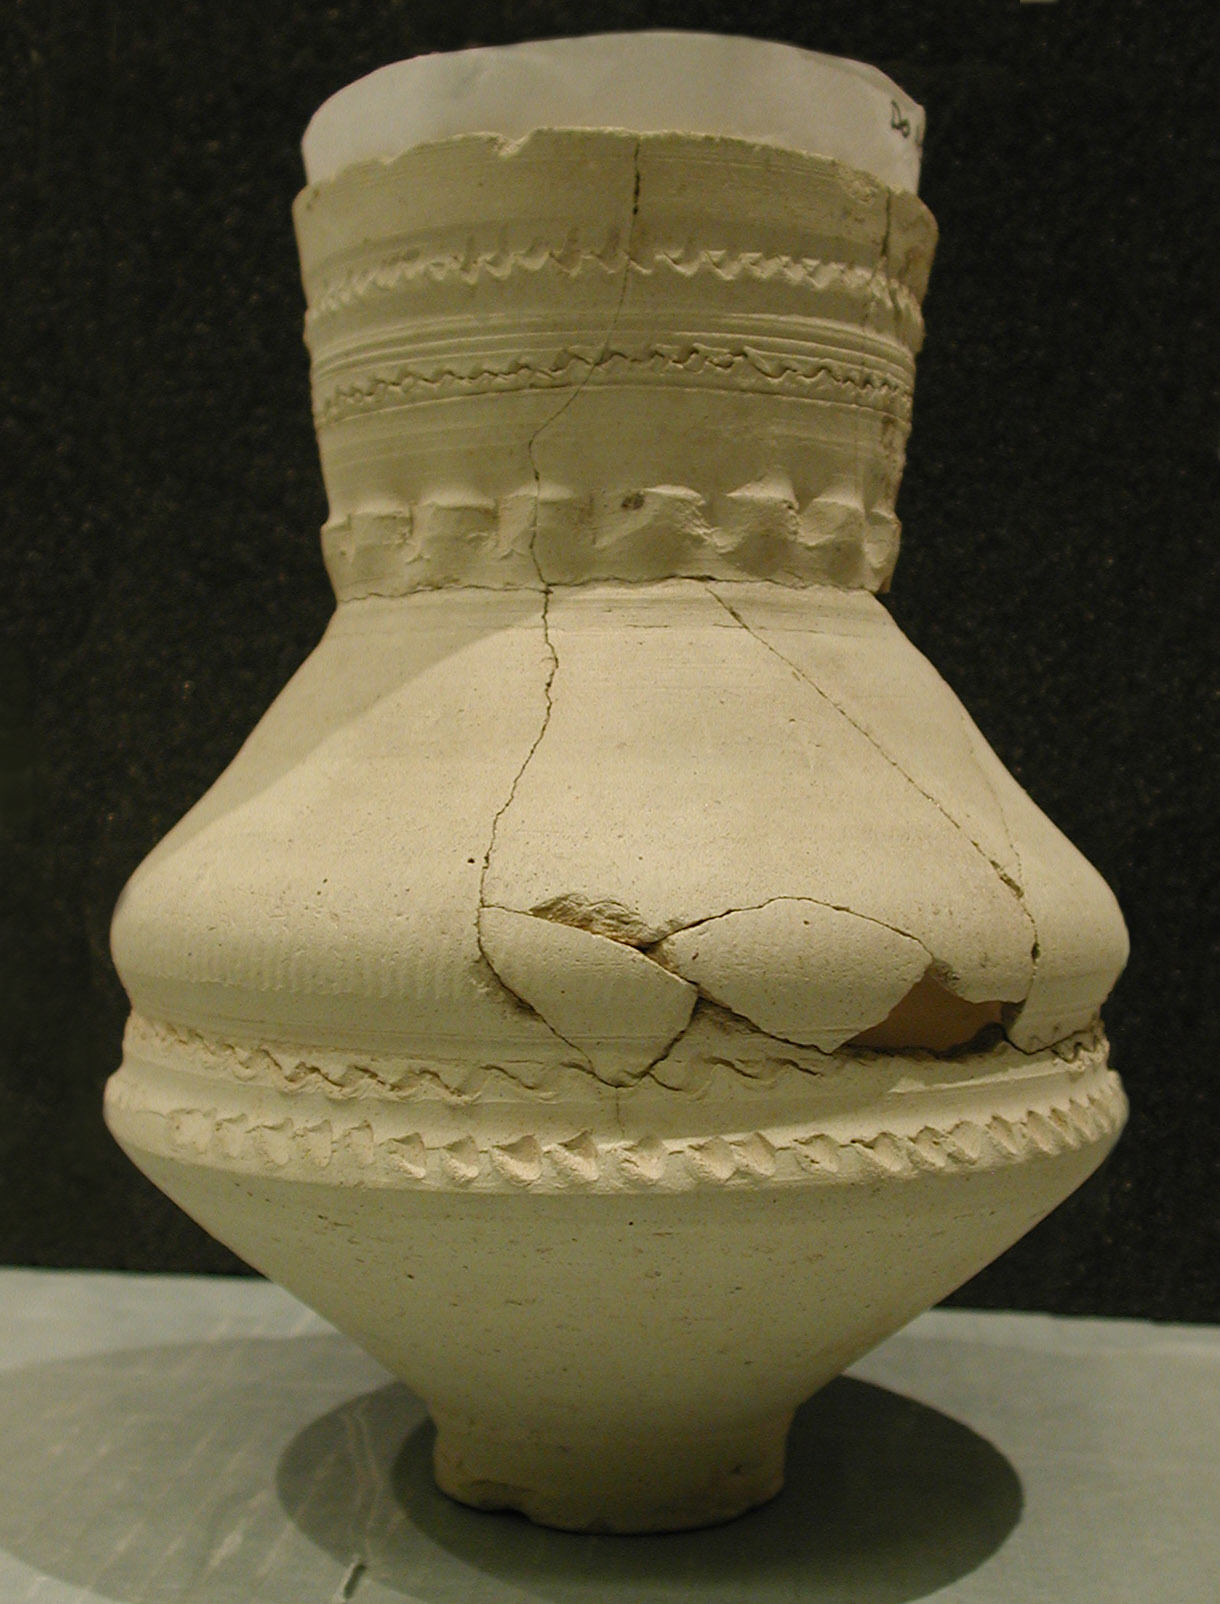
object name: jar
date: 901-1200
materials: earthenware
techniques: incising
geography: iran